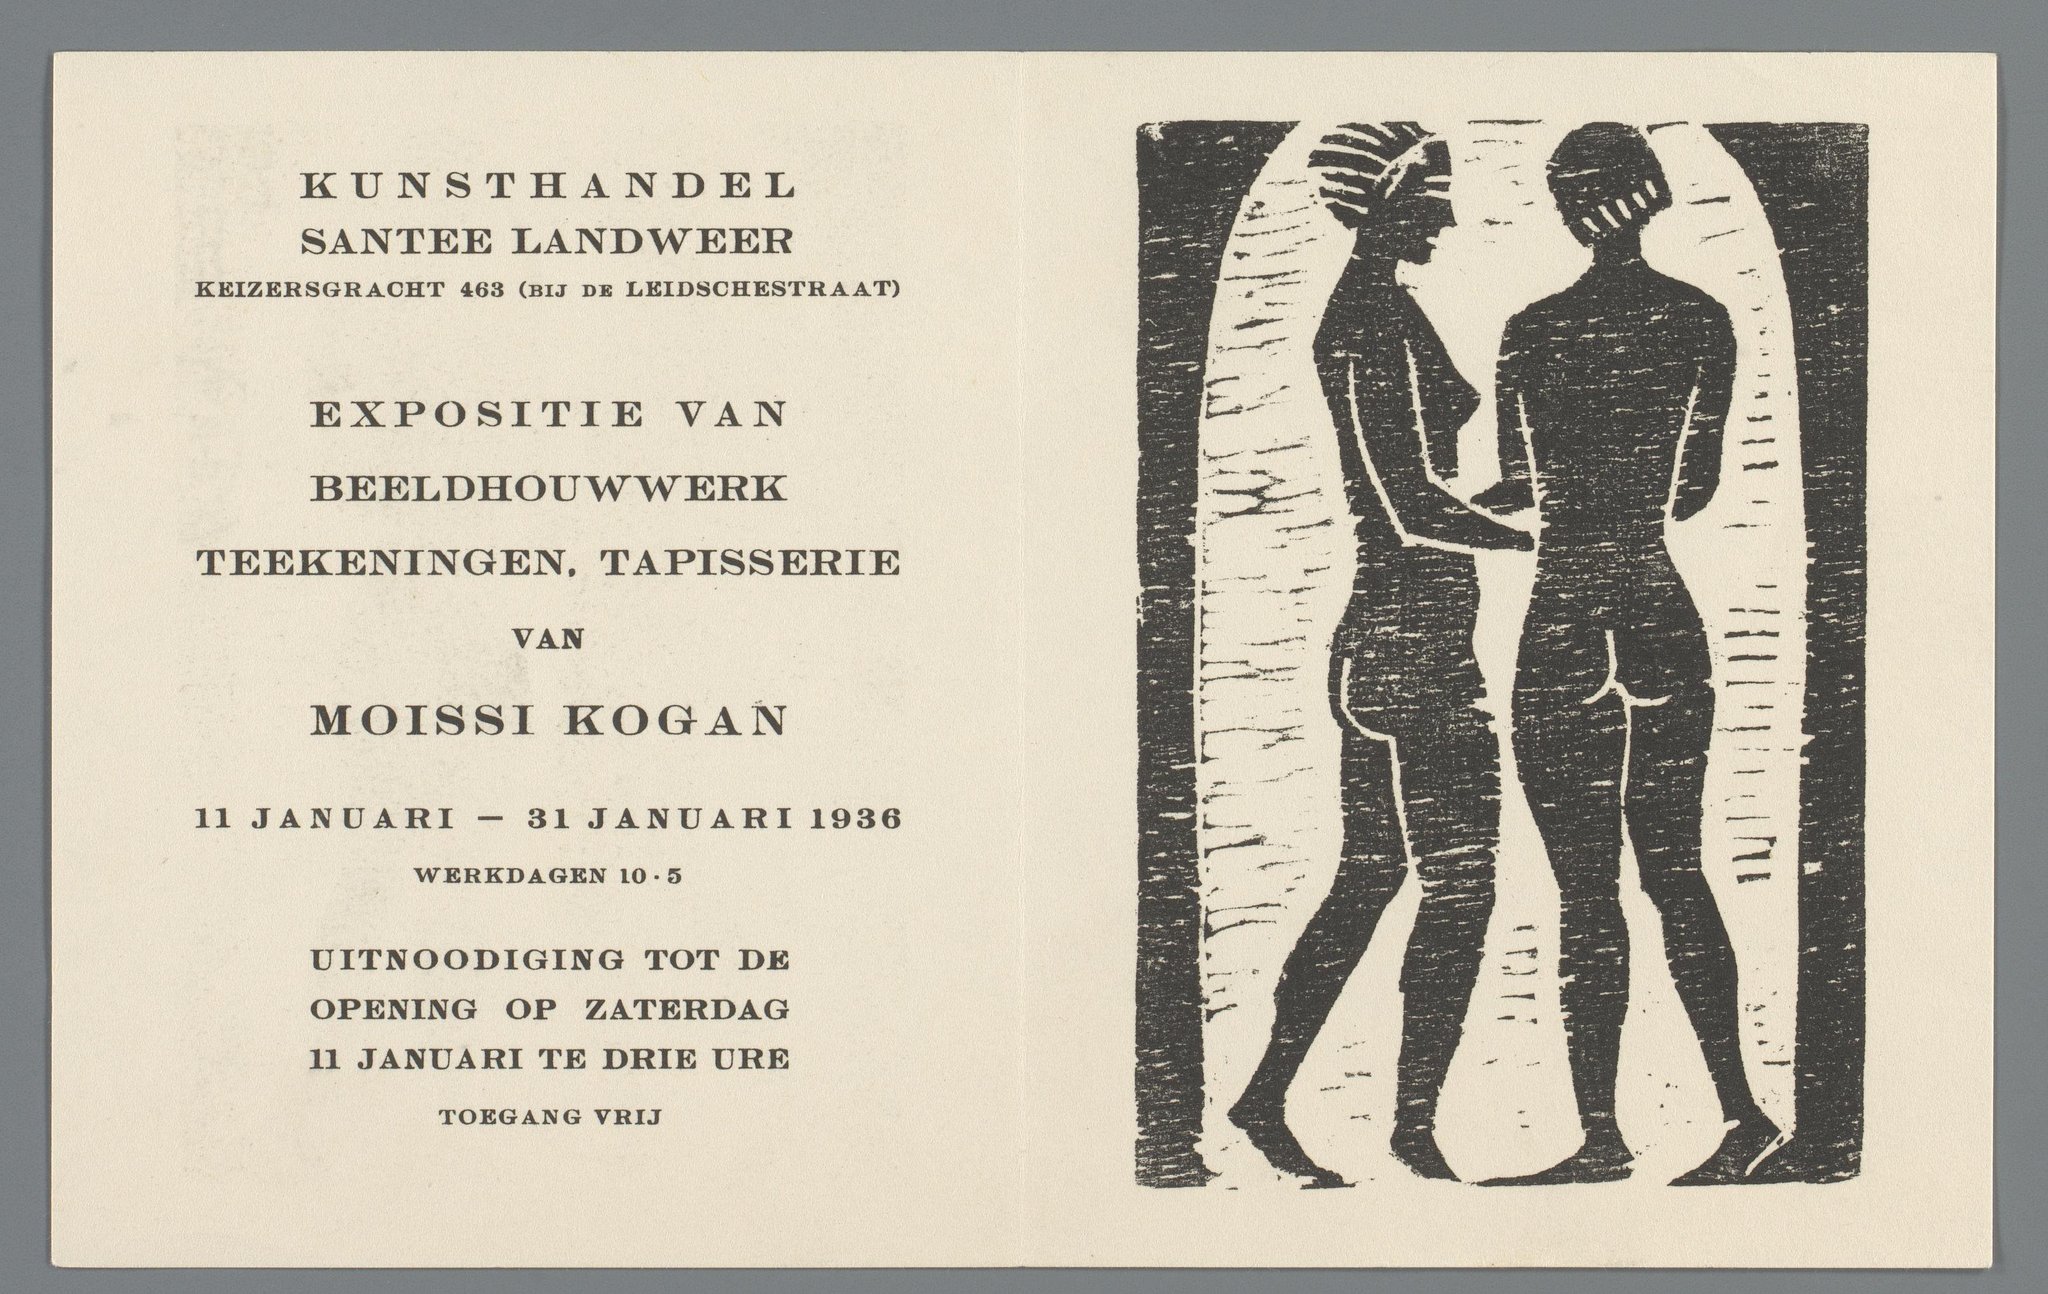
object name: print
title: Uitnodiging voor een expositie 'van beeldhouwwerk, teekeningen, tapisserie van Moissi Kogan'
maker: moissej kogan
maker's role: print maker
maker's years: 1879-1943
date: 1936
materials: paper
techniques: woodcut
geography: amsterdam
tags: print maker, moissej kogan, woman (showing herself) undressed, quasi-nude, collection, exhibition, show, amsterdam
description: Reachts twee staande vrouwelijke naakten. Links de tekst van de uitnodiging voor de opening van de expositie op 11 januari 1936 van de tentoonstelling die zou duren tot 31 januari 1936 bij Kunsthandel Santee Landweer te Amsterdam.